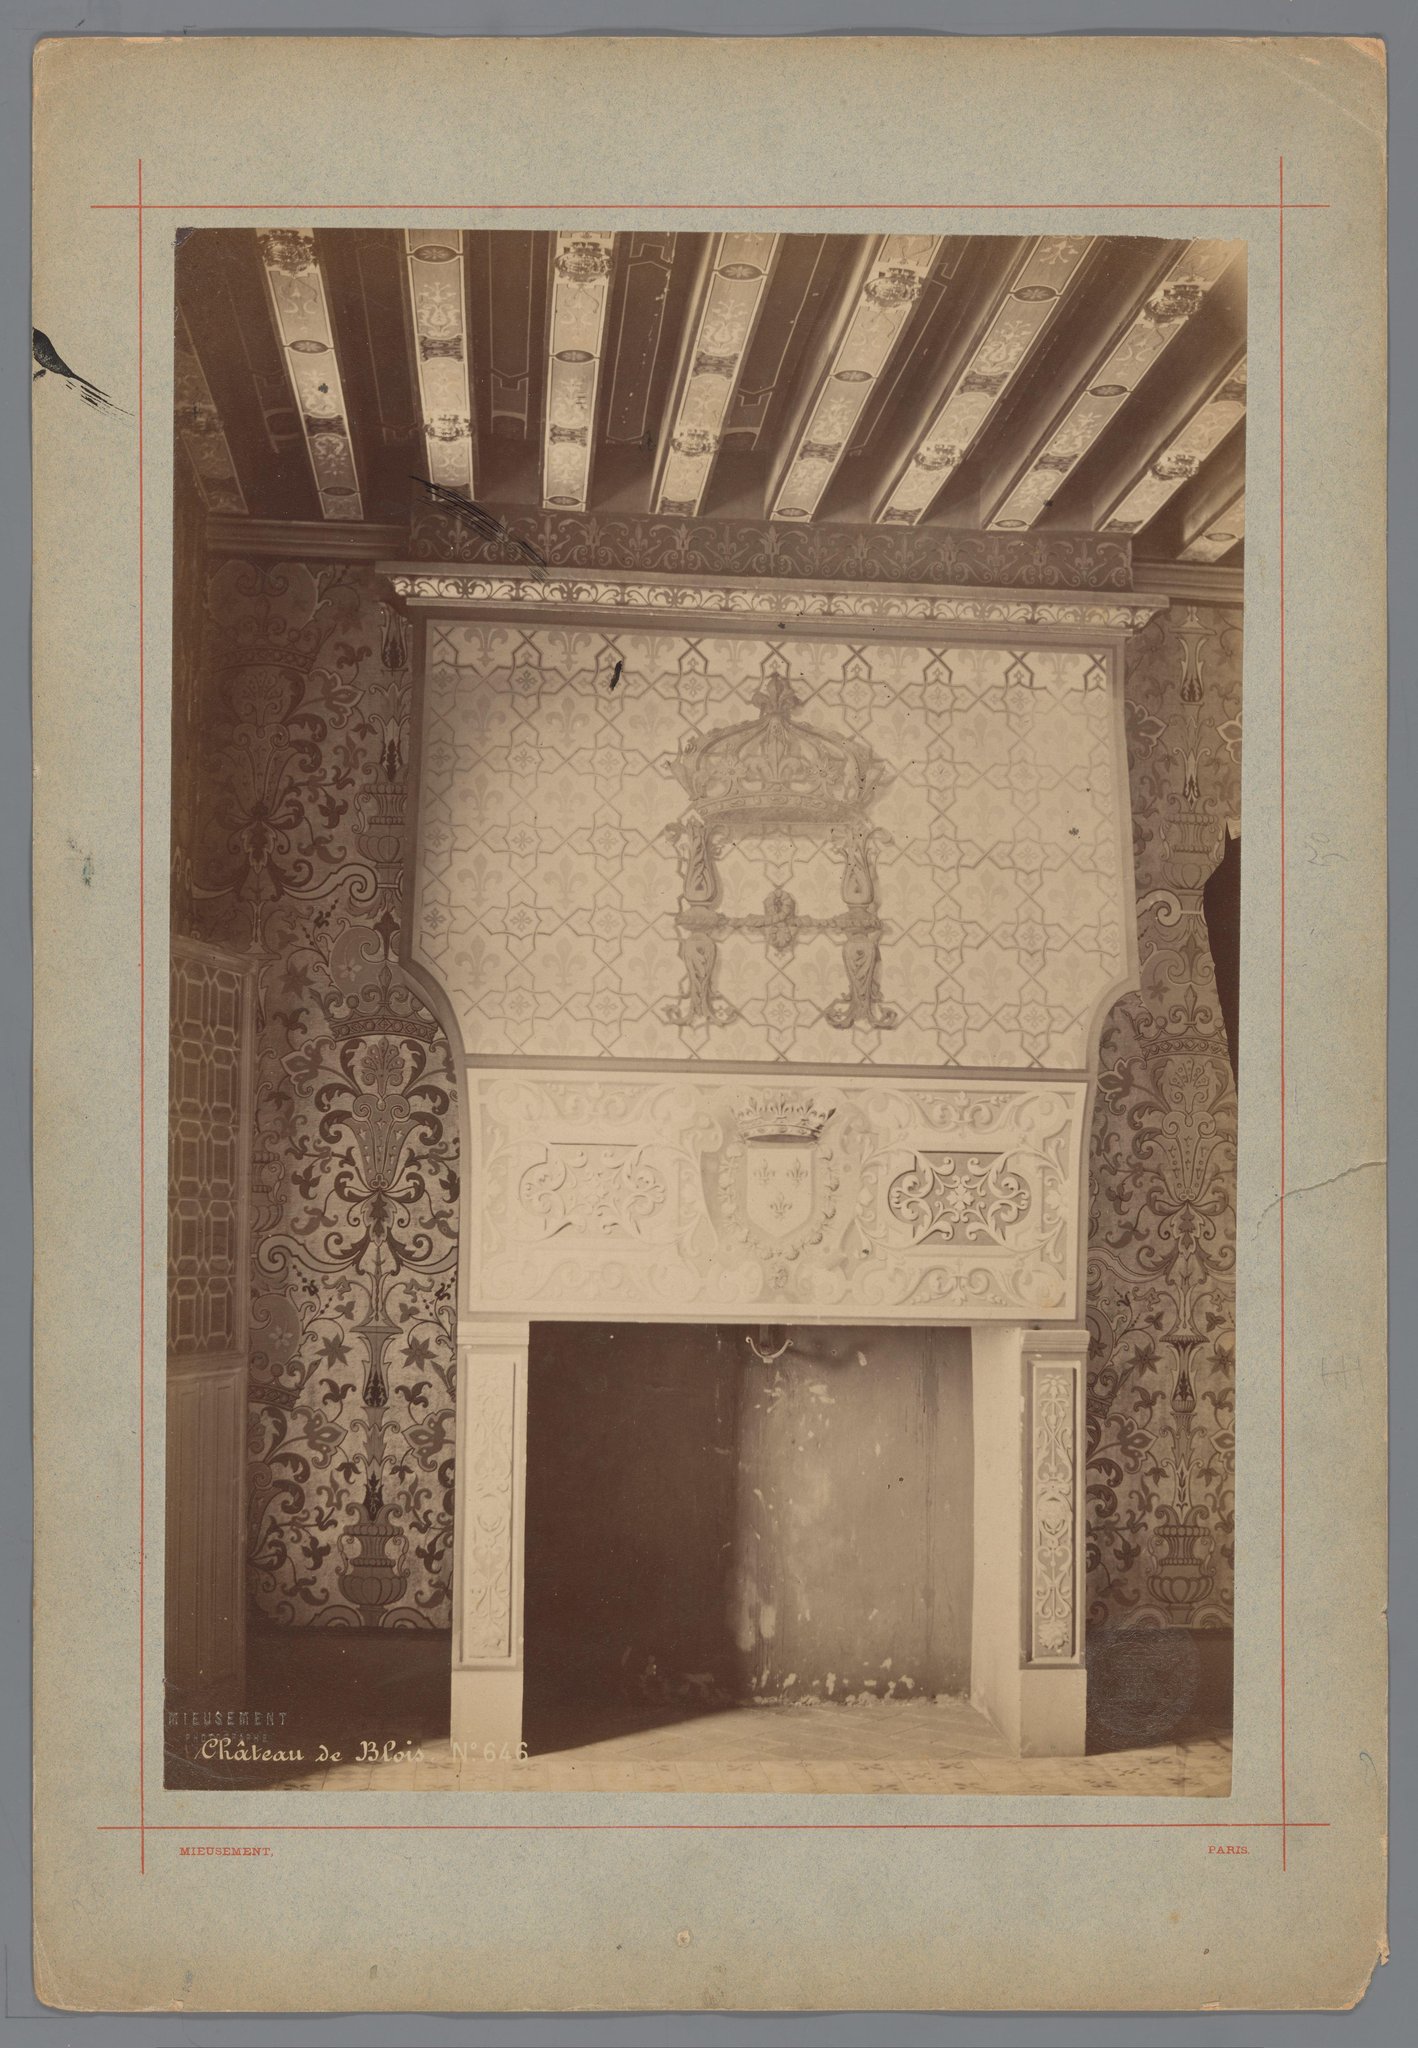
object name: photograph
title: Château de Blois.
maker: séraphin-médéric mieusement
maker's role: fotograaf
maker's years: 1840-1905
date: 1875-1900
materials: cardboard, photographic support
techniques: albumen print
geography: blois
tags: floral interlace ~ ornament, castle, open hearth, fire-place, interior ~ representation of a building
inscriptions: name: ‘Monsters worden door de Representant J. A. G. de LEUR-den haag op franco aanvrage verzonden’, collector's mark: Lugt 3937, inscription: ‘MONUMENTS HISTORIQUES’, number: ‘No. 646’, name: ‘MIEUSEMENT PHOTOGRAPHE’, inscription: ‘pl 12’, name: ‘MIEUSEMENT, PARIS’